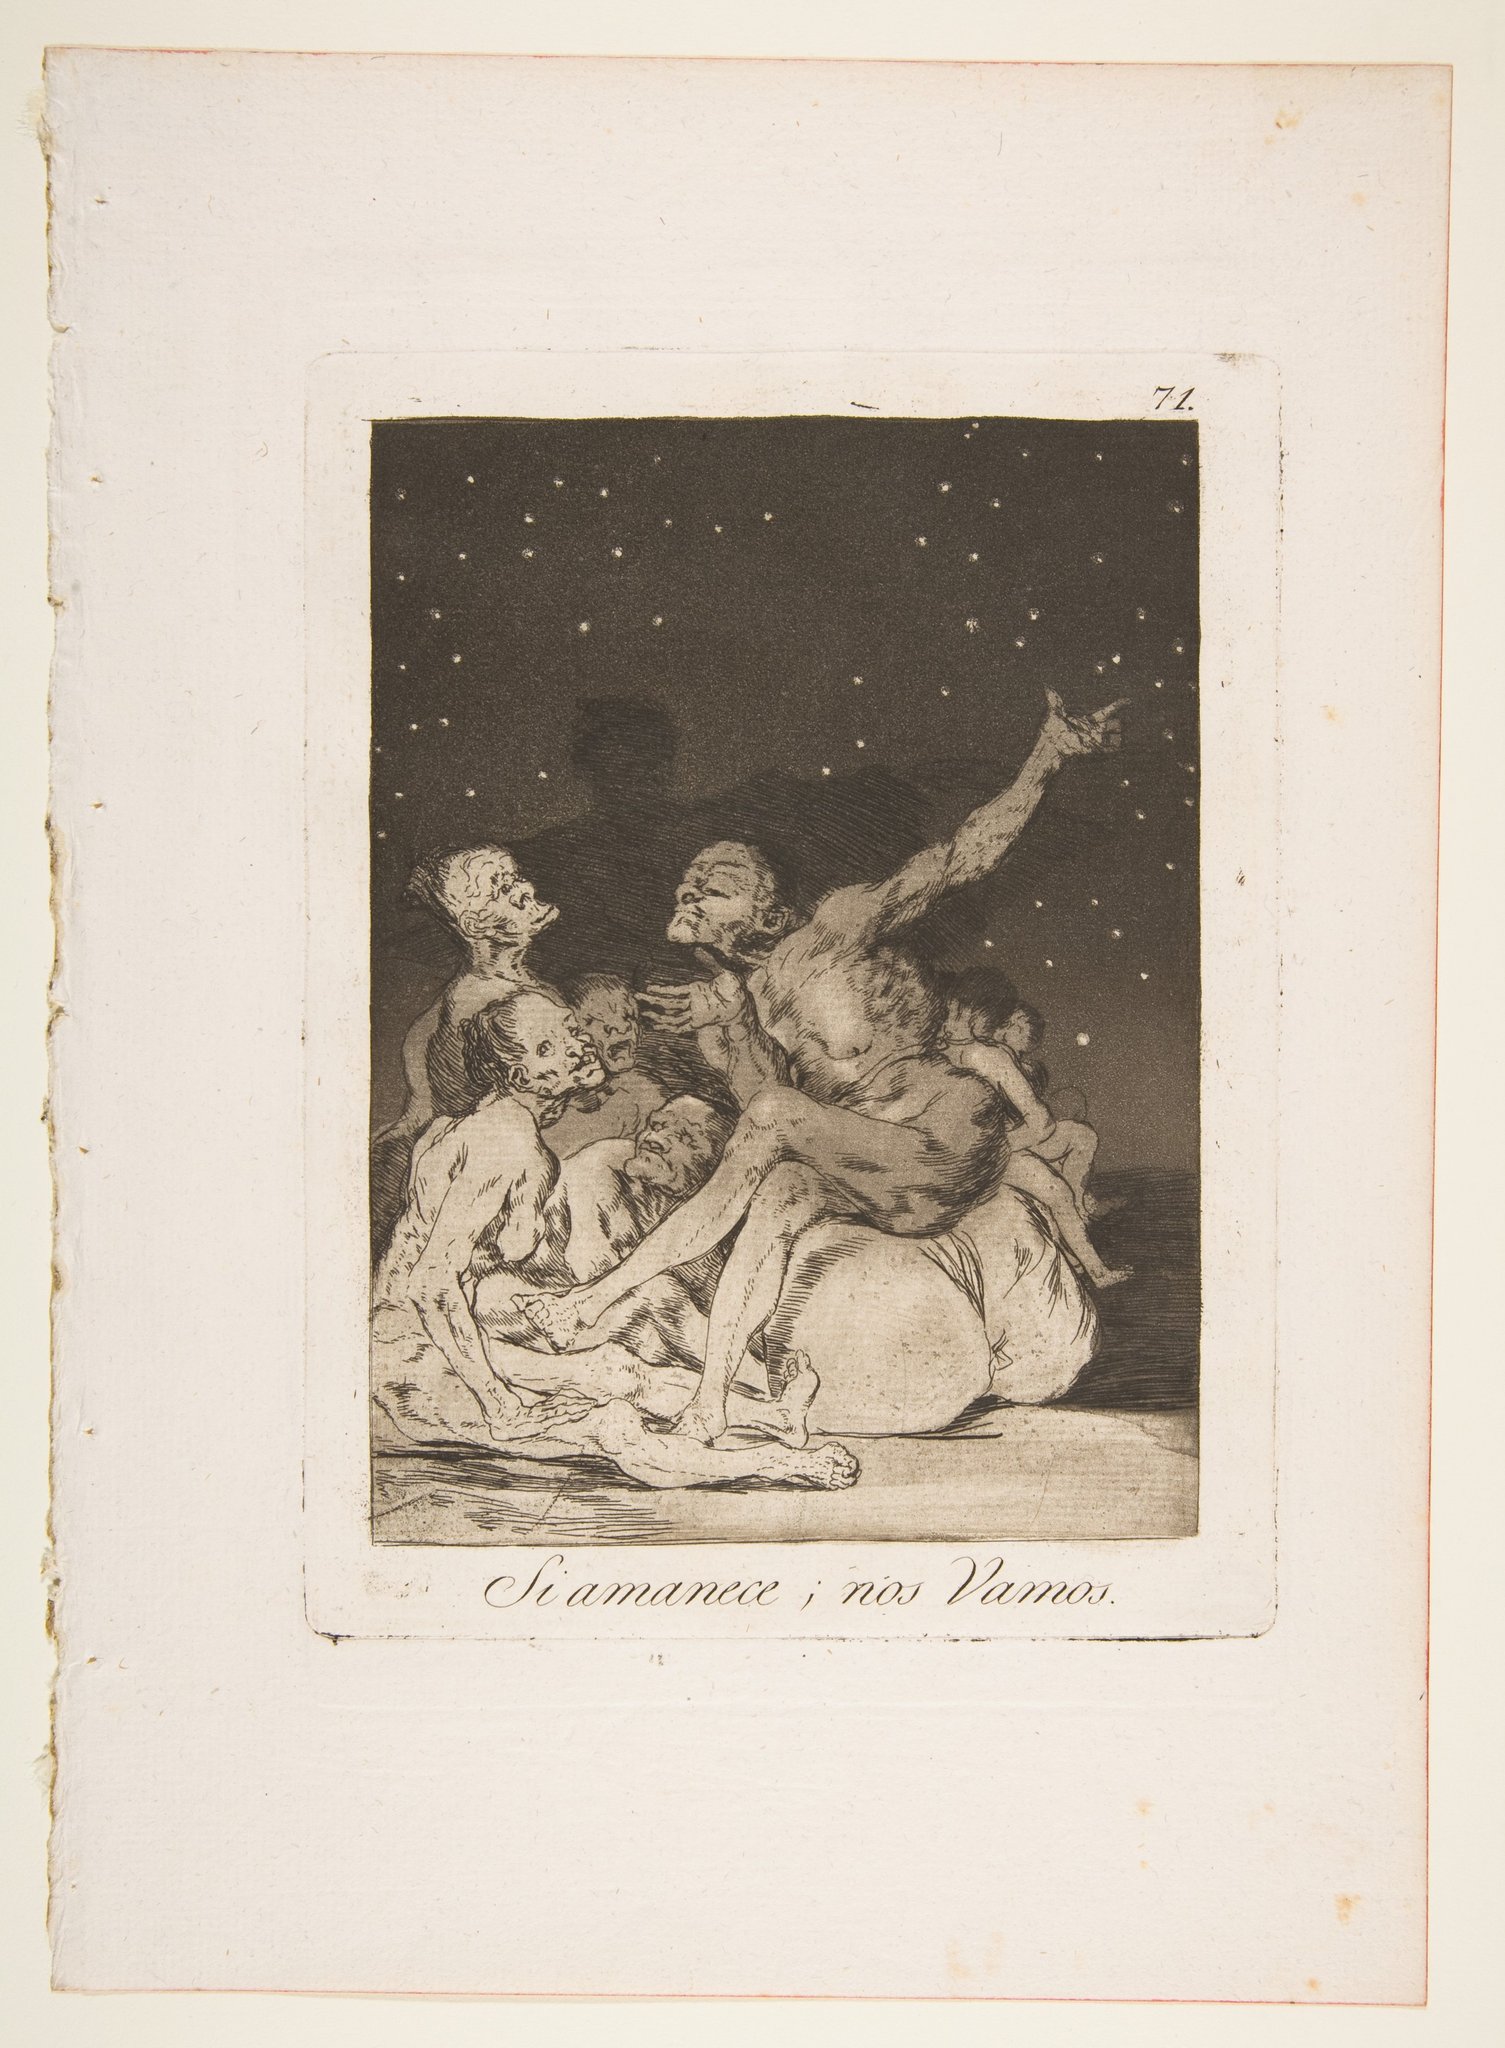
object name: print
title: Plate 71 from "Los Caprichos": When day breaks we will be off (Si amanece; nos Vamos)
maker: goya (francisco de goya y lucientes)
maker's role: artist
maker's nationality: spanish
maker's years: 1746-1828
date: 1799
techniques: aquatint, engraving, burnishing, etching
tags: human figures